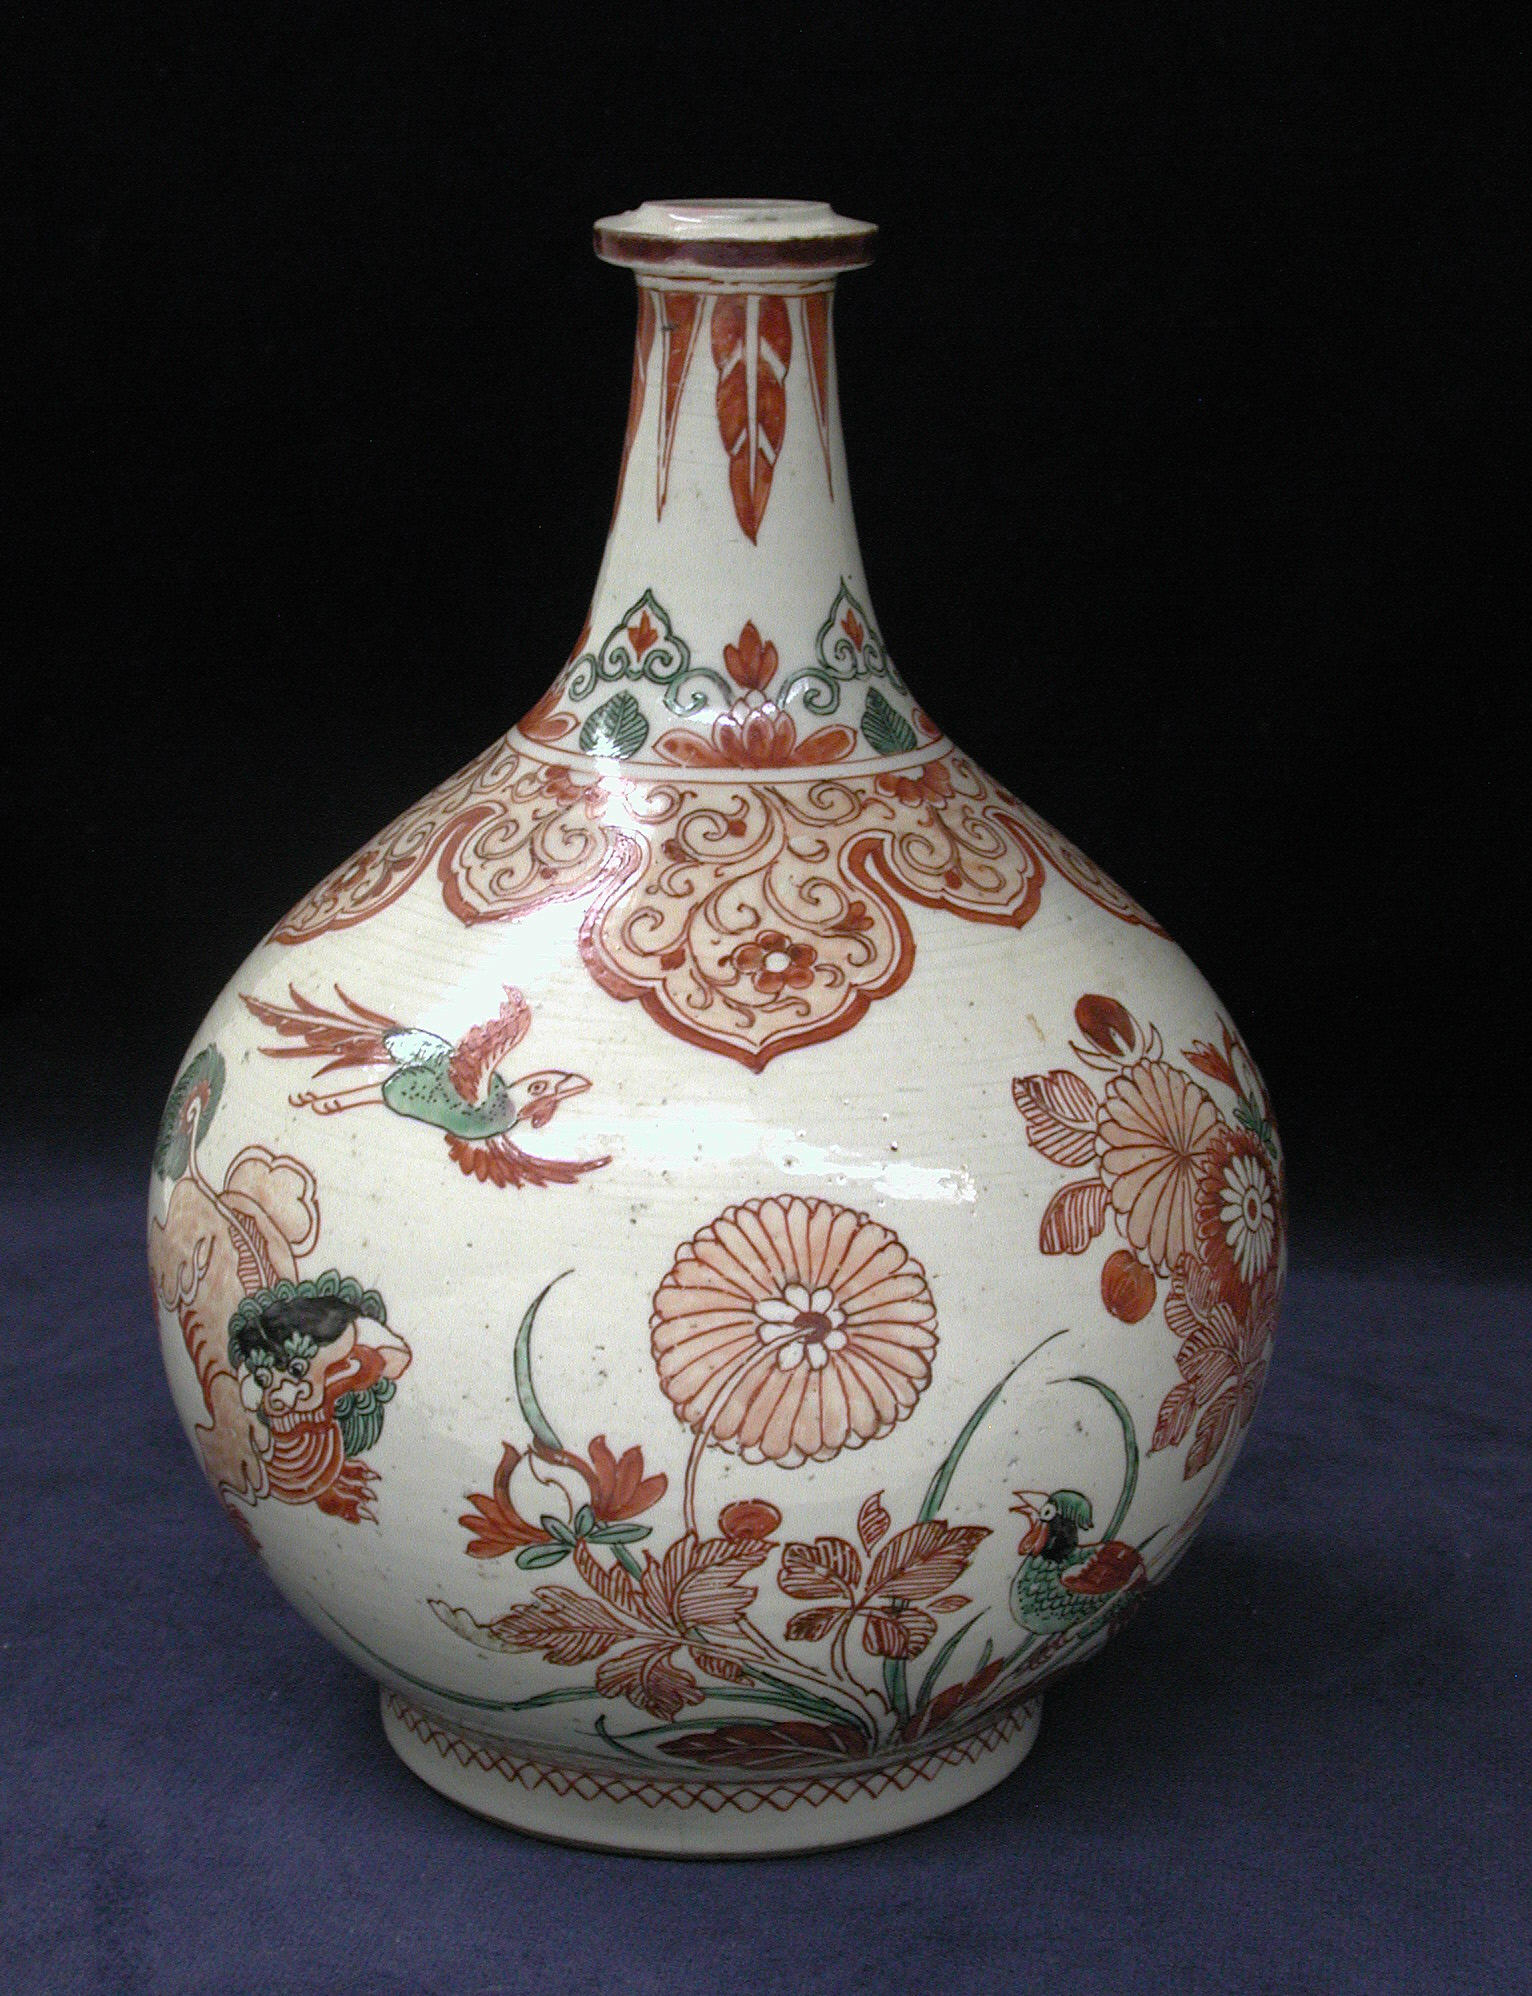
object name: bottle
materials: hard paste porcelain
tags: birds,flowers